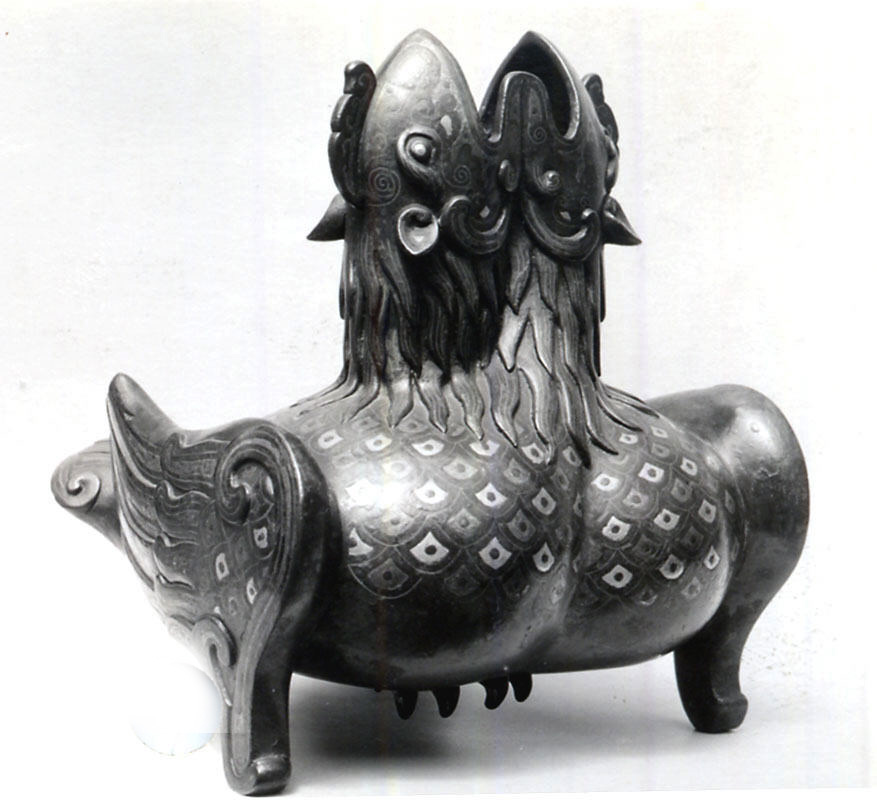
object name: wine vessel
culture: chinese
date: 1368-1644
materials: bronze, gold, silver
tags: animals